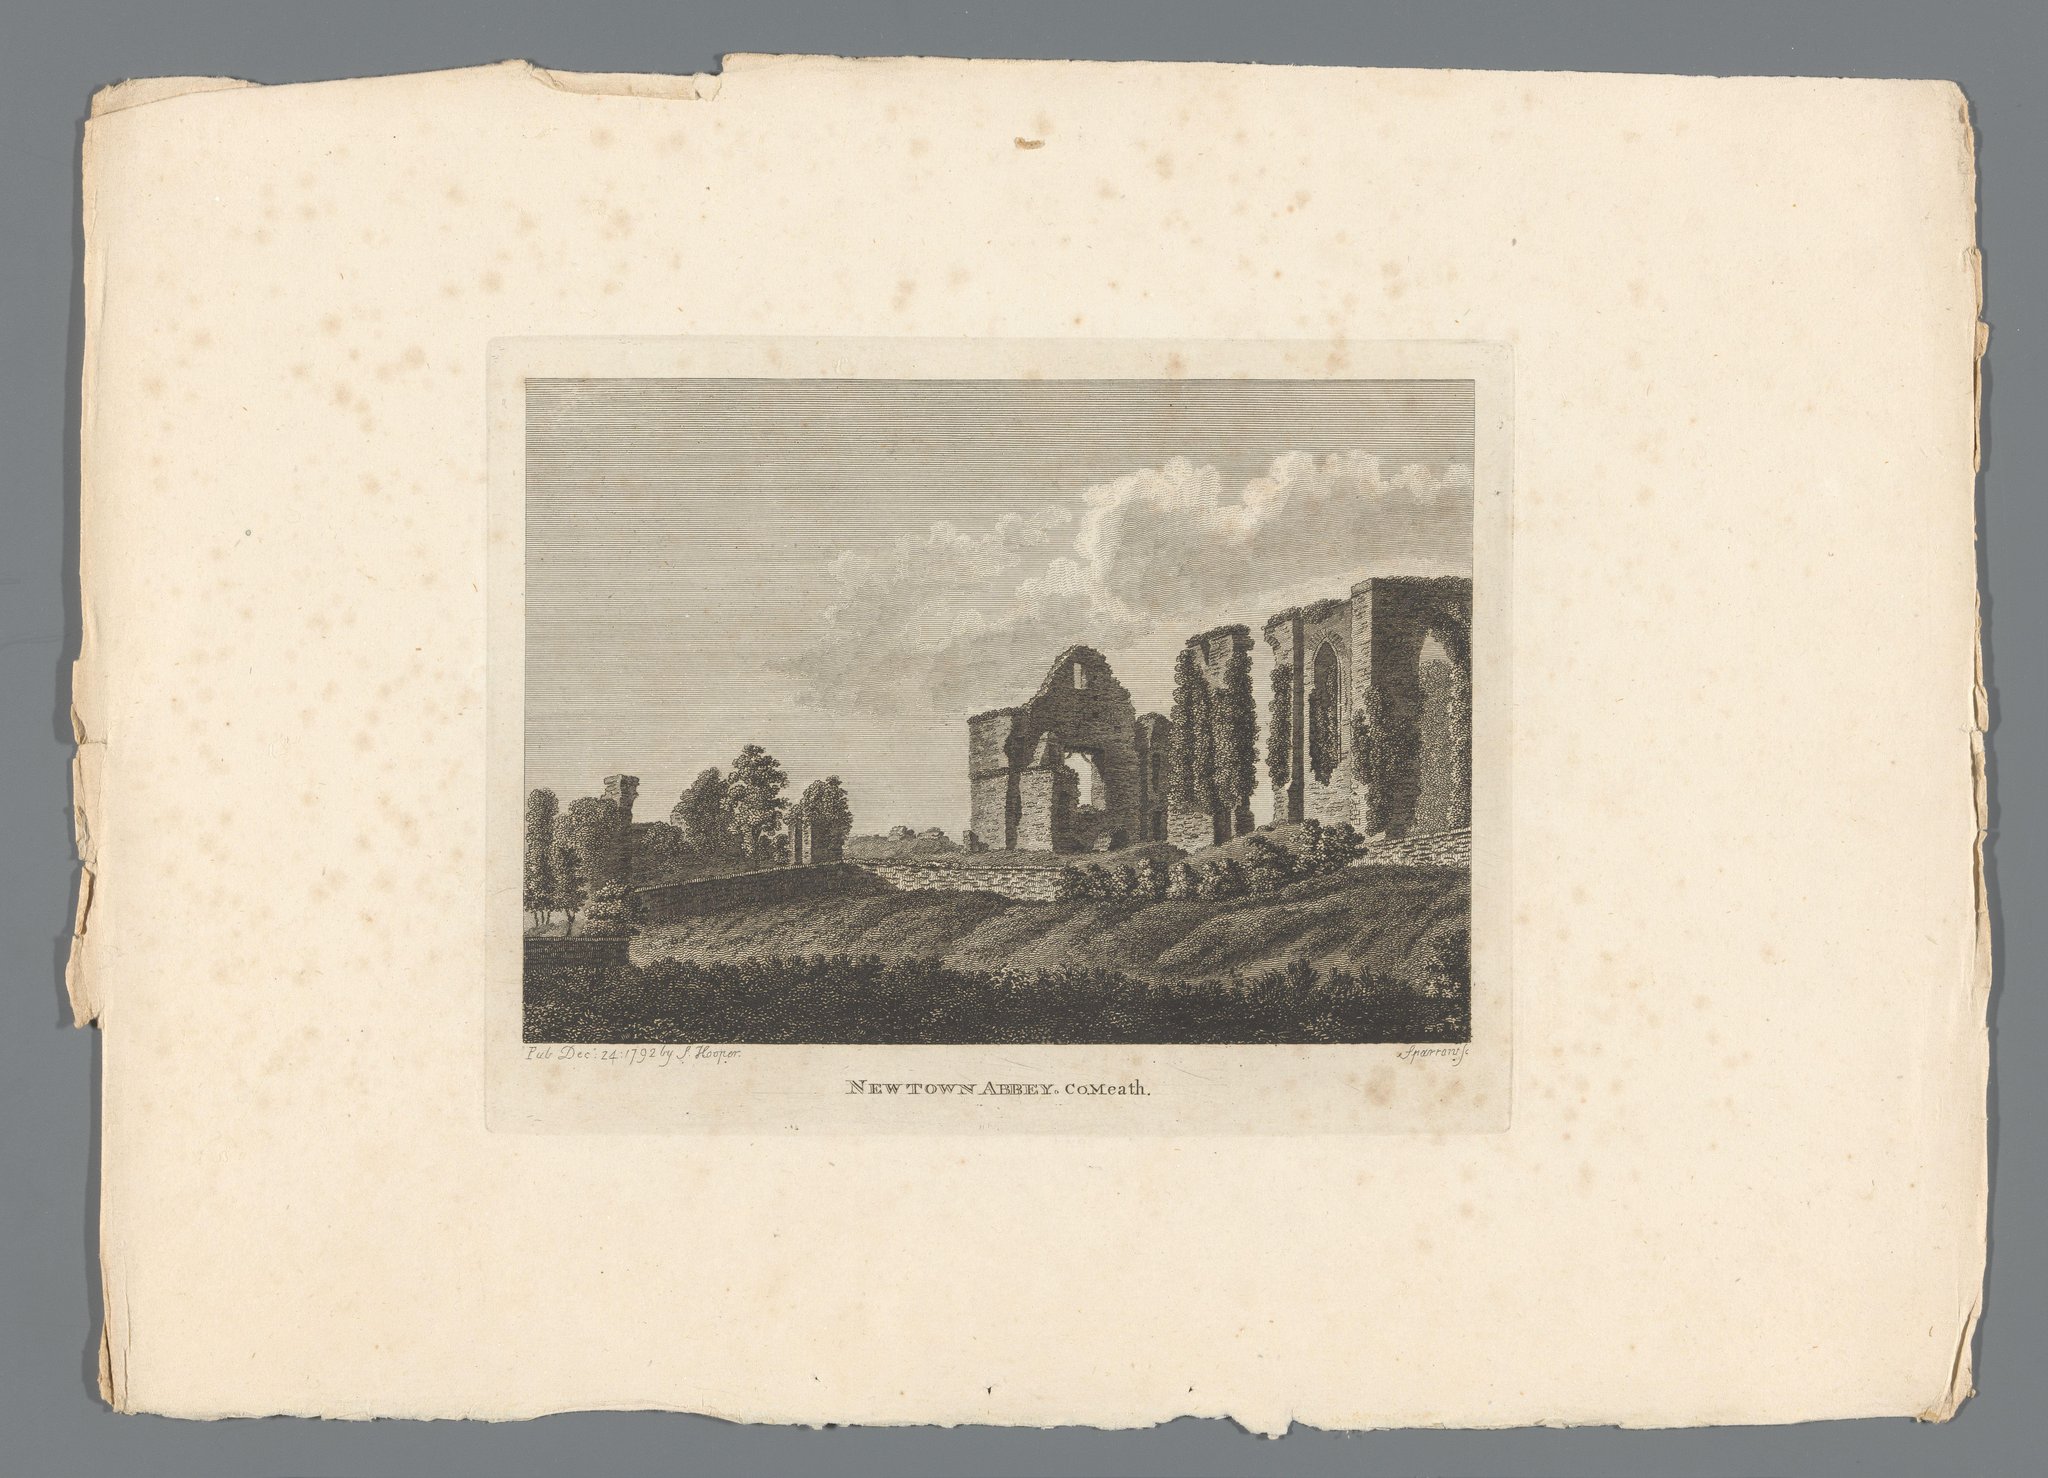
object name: print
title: Newtown Abbey. Co.Meath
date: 1792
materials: paper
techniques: etching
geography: london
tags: abbey, monastery, convent ~ roman catholic church, landscape with ruins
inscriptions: date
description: Prent verschenen in: Grose, Francis. The antiquities of Ireland. Londen: S. Hooper, 1795, dl. 2.